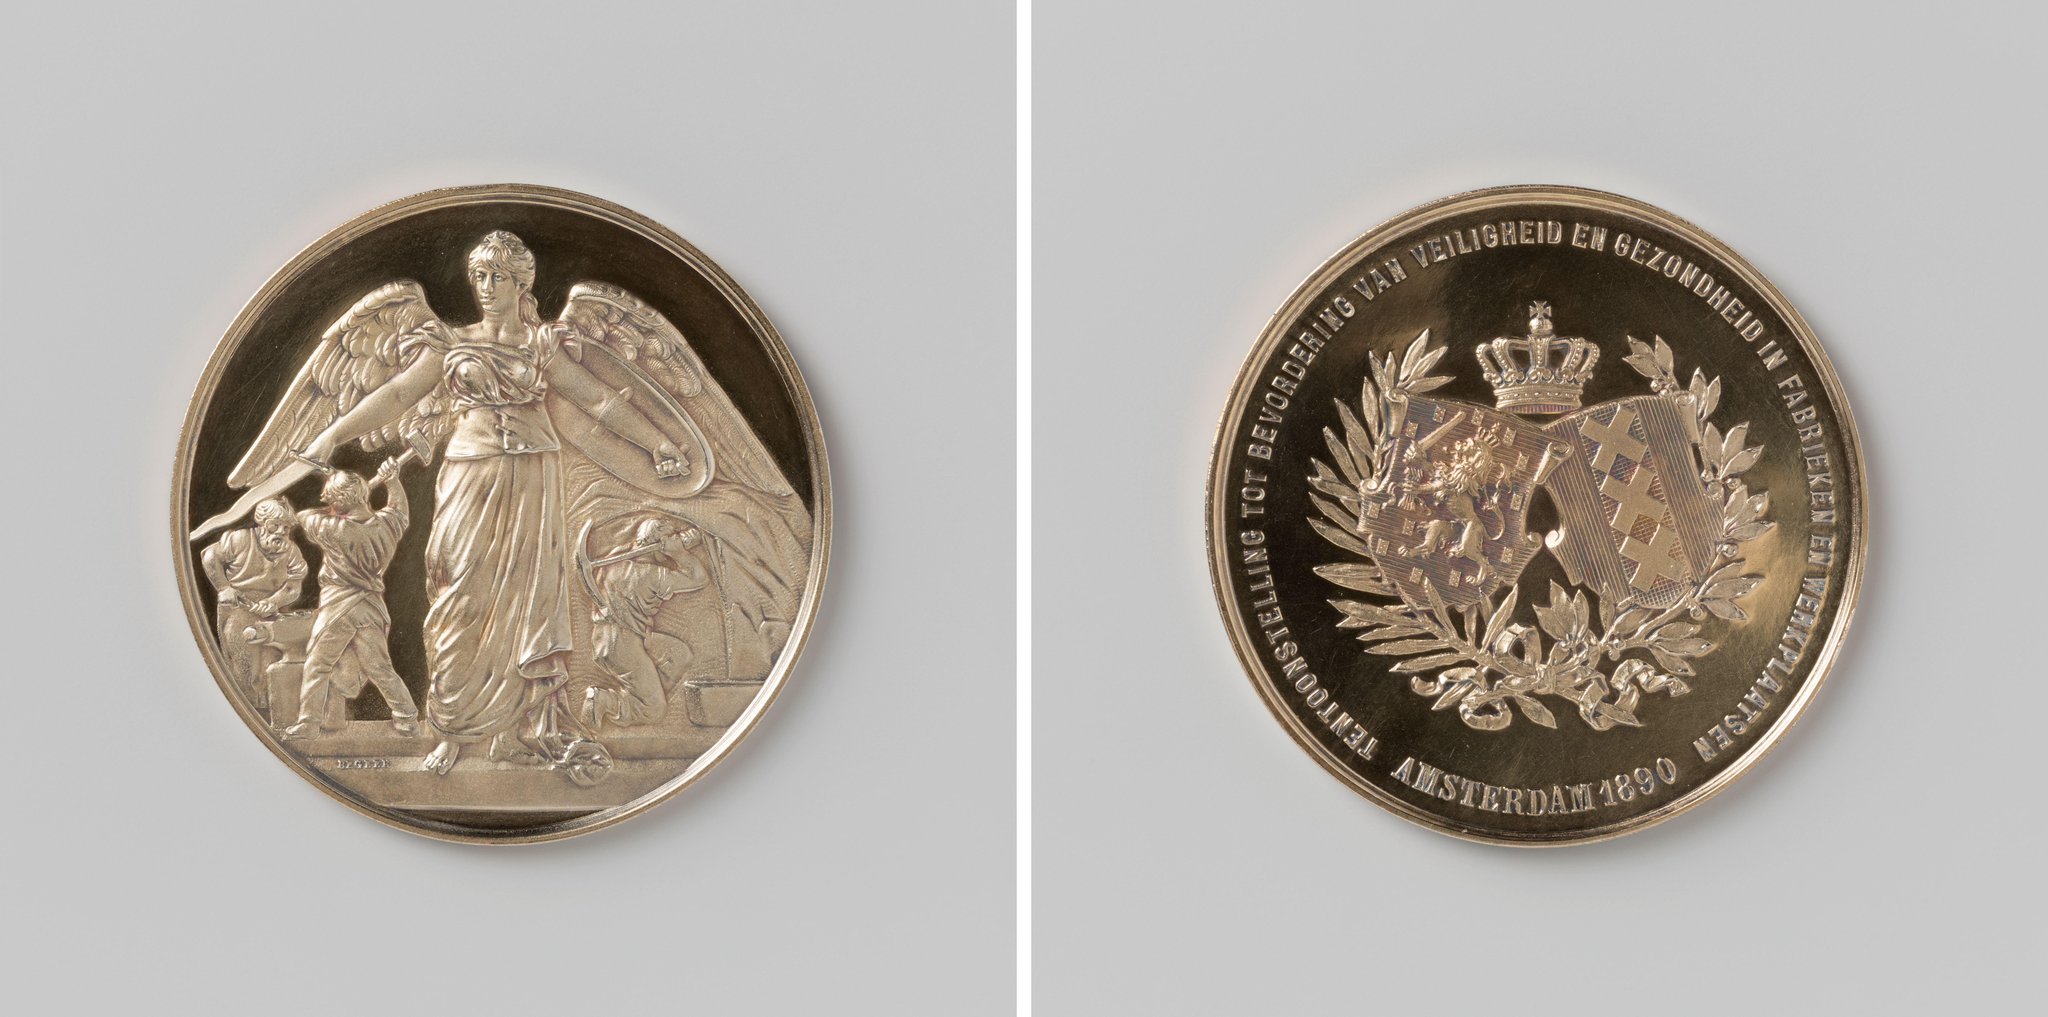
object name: medal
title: Tentoonstelling tot bevordering van veiligheid en gezondheid in fabrieken en werkplaatsen te Amsterdam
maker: georg haas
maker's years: 1756-1817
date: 1890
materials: silver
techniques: striking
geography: utrecht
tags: amsterdam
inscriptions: signature: ‘BEGEER’, circumscription: ‘TENTOONSTELLING TOT BEVORDERING VAN VEILIGHEID EN GEZONDHEID IN FABRIEKEN EN WERKPLAATSEN / AMSTERDAM 1890’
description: Zilveren penning. Voorzijde: gevleugelde Genius houdt met linkerhand zwaard boven twee smeden, die bij aanbeeld werken en met linkerhand schild boven mijnwerker, die houweel boven zijn hoofd heft. Keerzijde: twee wapenschilden onder een kroon binnen tot krans samengebonden lauwer- en eiketak en omschrift.